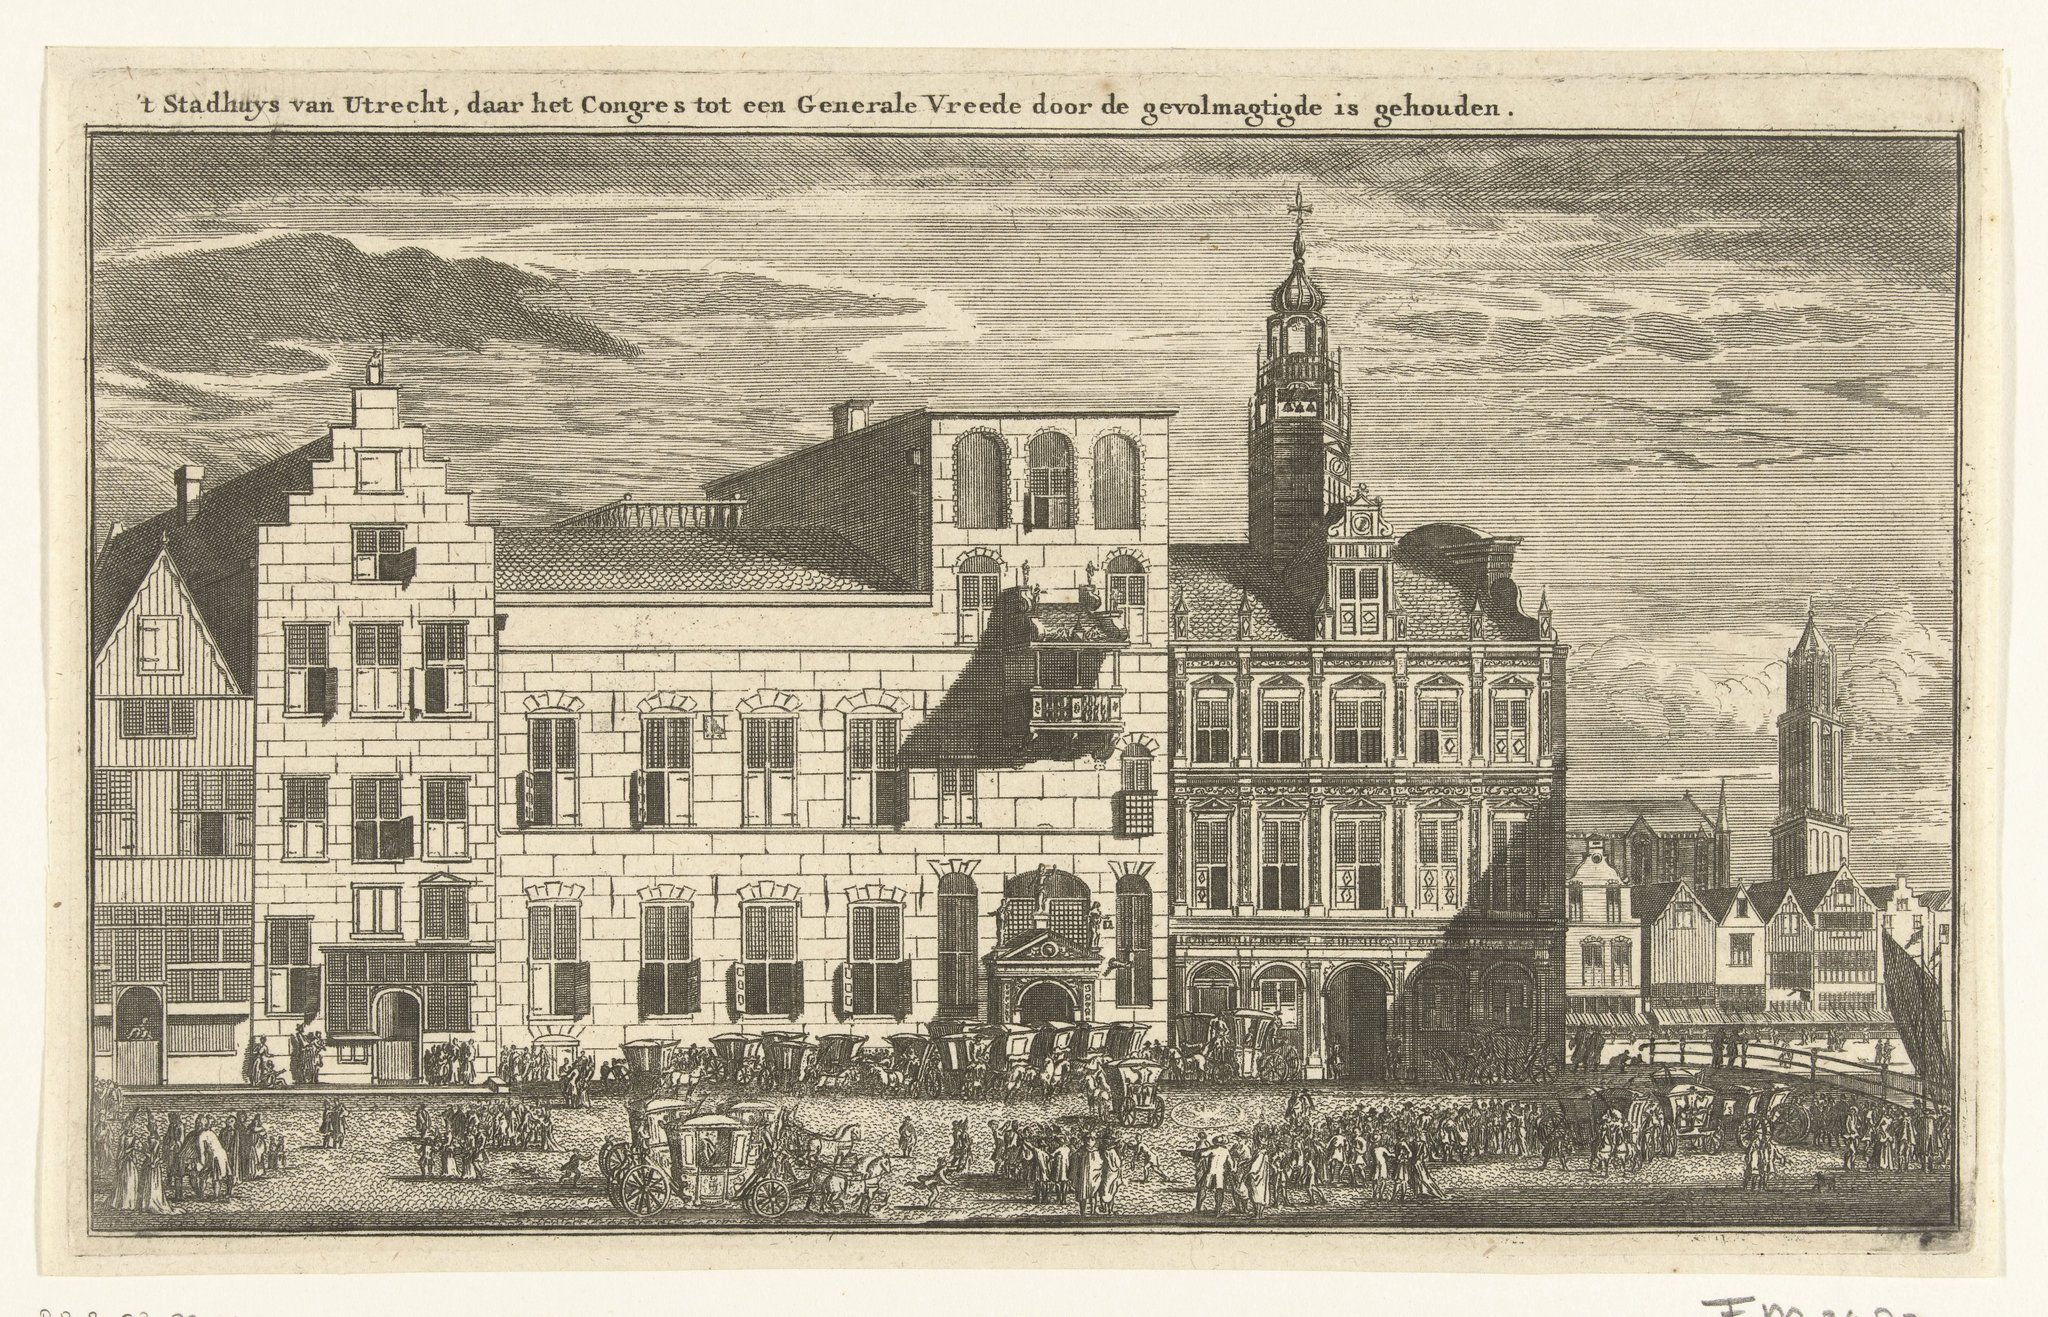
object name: history print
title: 't Stadhuys van Utrecht, daar het Congres tot een Generale Vreede door de gevolmagtigde is gehouden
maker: Anonymous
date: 1712-1750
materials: paper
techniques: etching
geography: northern netherlands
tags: peace negotiations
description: De vredesonderhandelingen in de gebouwen van het oude stadhuis van Utrecht, begonnen op 29 januari 1712. Rechts op de achtergrond de Dom. Op de voorgrond de aankomst van de koetsen van de onderhandelaars bij de toegang tot het stadhuis.